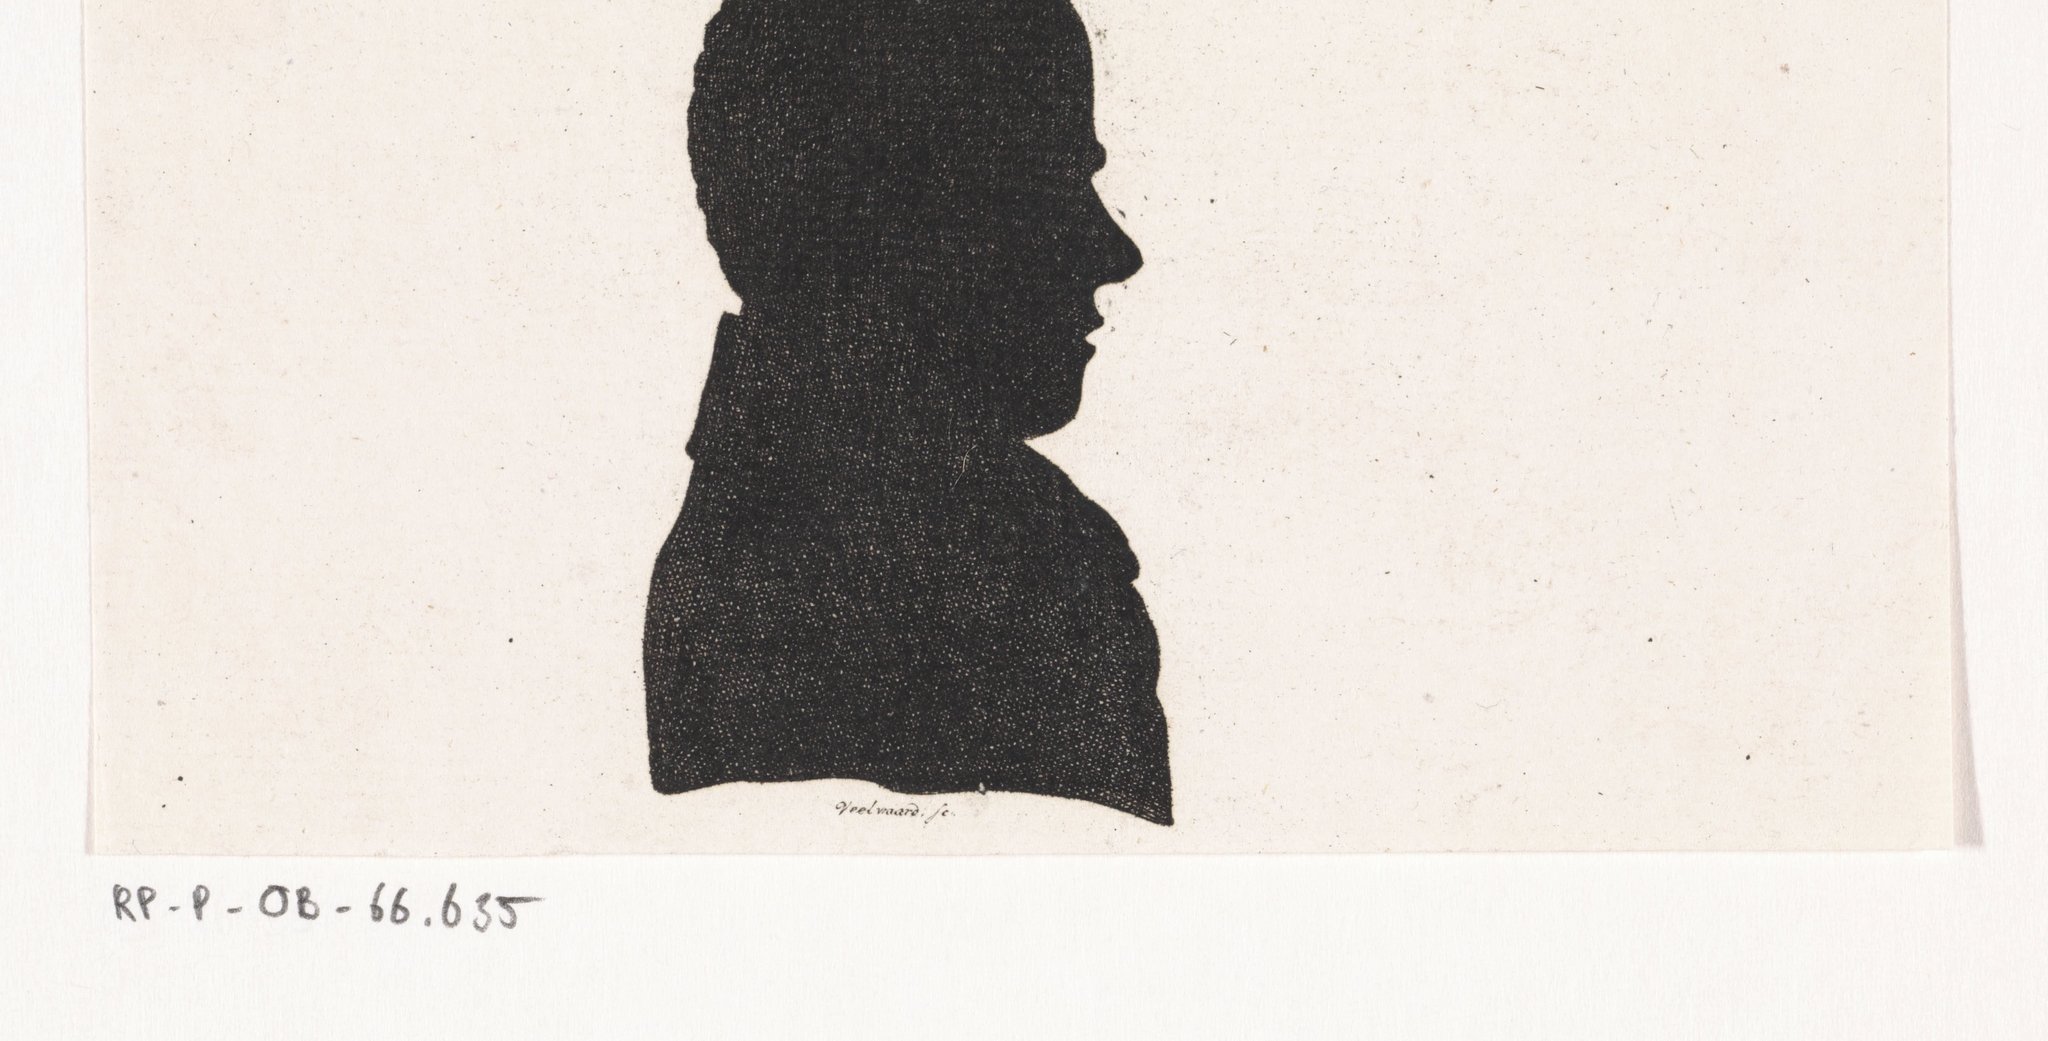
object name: print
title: Silhouetportret van de schrijver Heabele Potter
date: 1806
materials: paper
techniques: etching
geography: haarlem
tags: surabaya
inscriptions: number: ‘576 (?)’, collector's mark: Lugt 2228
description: Fragment van de titelpagina voor: Potter, Heabele. Lotgevallen en ontmoetingen op eene mislukte reize naar de Kaap de Goede Hoop in de jaren 1804, 1805 en 1806. In brieven aan eenen vriend. Haarlem: Weduwe Adriaan